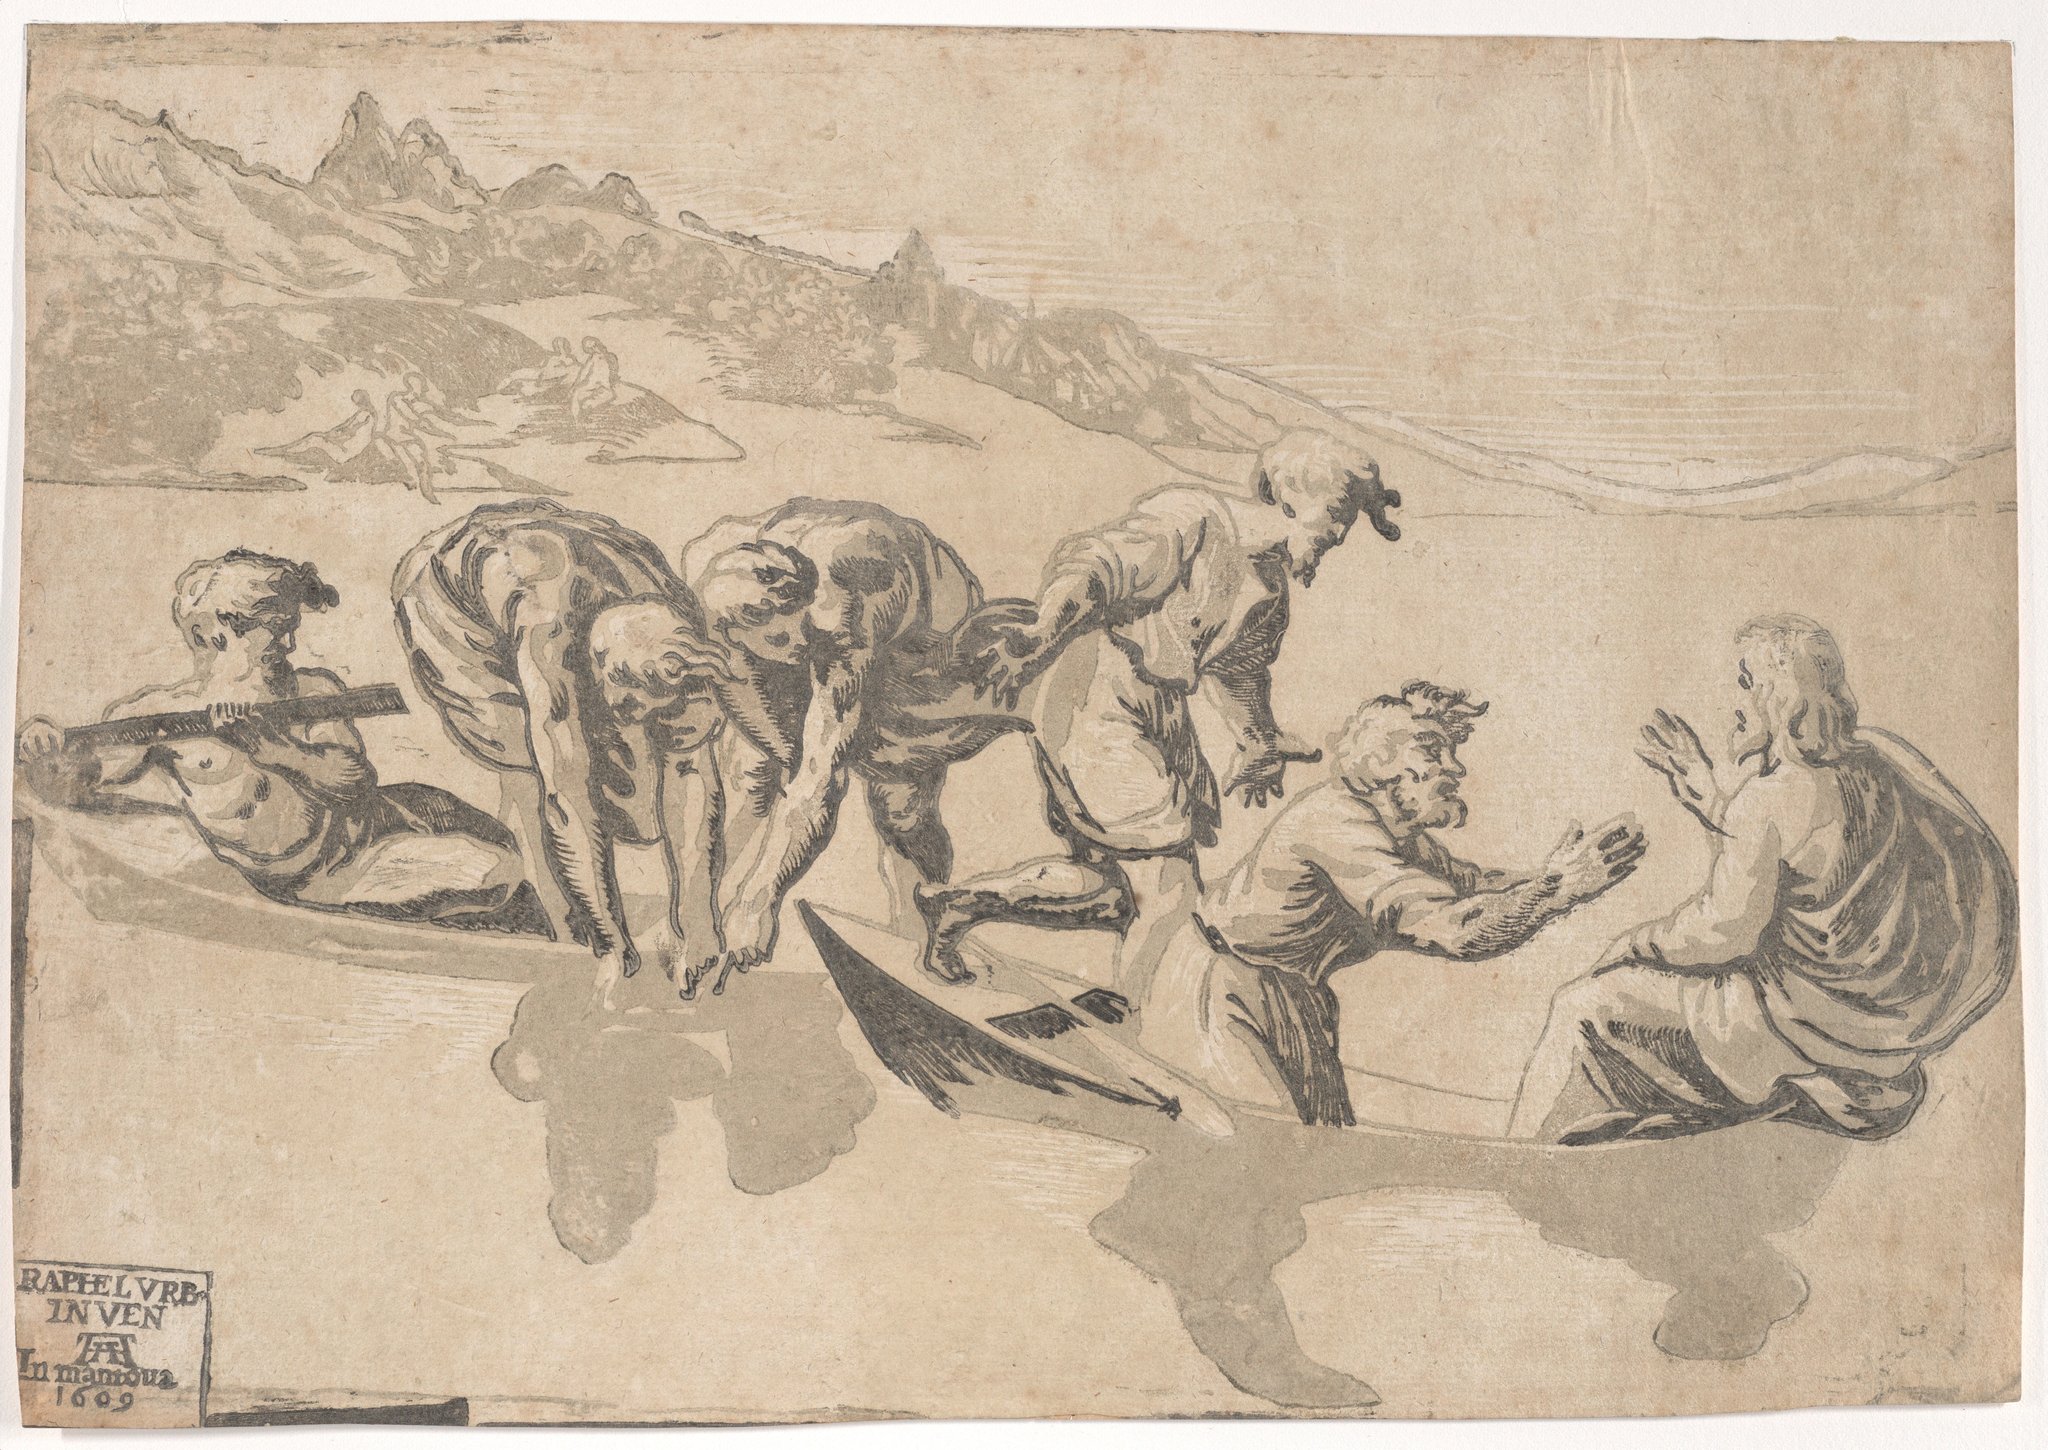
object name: print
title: The Miraculous Draught of Fishes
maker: niccolò vicentino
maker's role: artist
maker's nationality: italian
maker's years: 1510-1550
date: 1540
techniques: woodcut